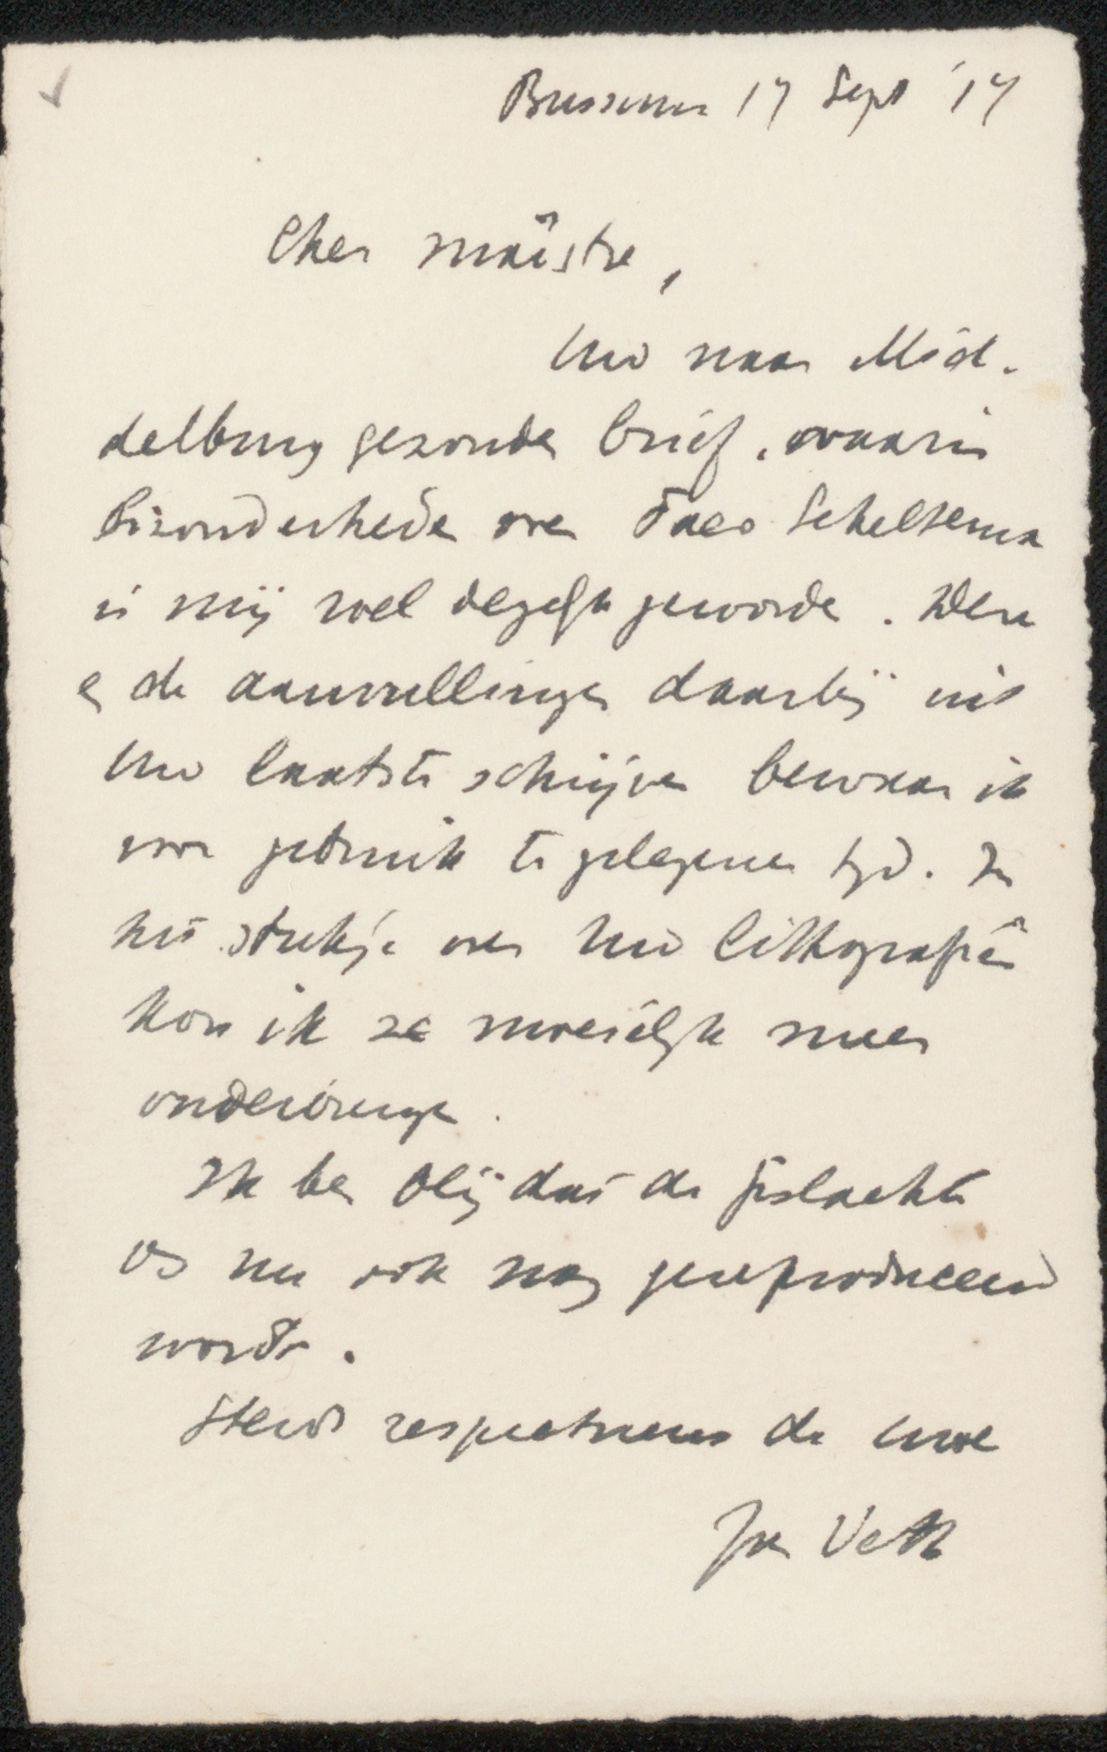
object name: letter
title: Brief aan August Allebé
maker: jan veth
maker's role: designer, draughtsman, painter, print maker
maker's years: 1864-1925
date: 1917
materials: ink, paper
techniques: pen, writing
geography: bussum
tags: august allebé, arnhem, the hague, taco jan scheltema, the graphic arts, printed matter, middelburg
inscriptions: collector's mark: ‘RPK’